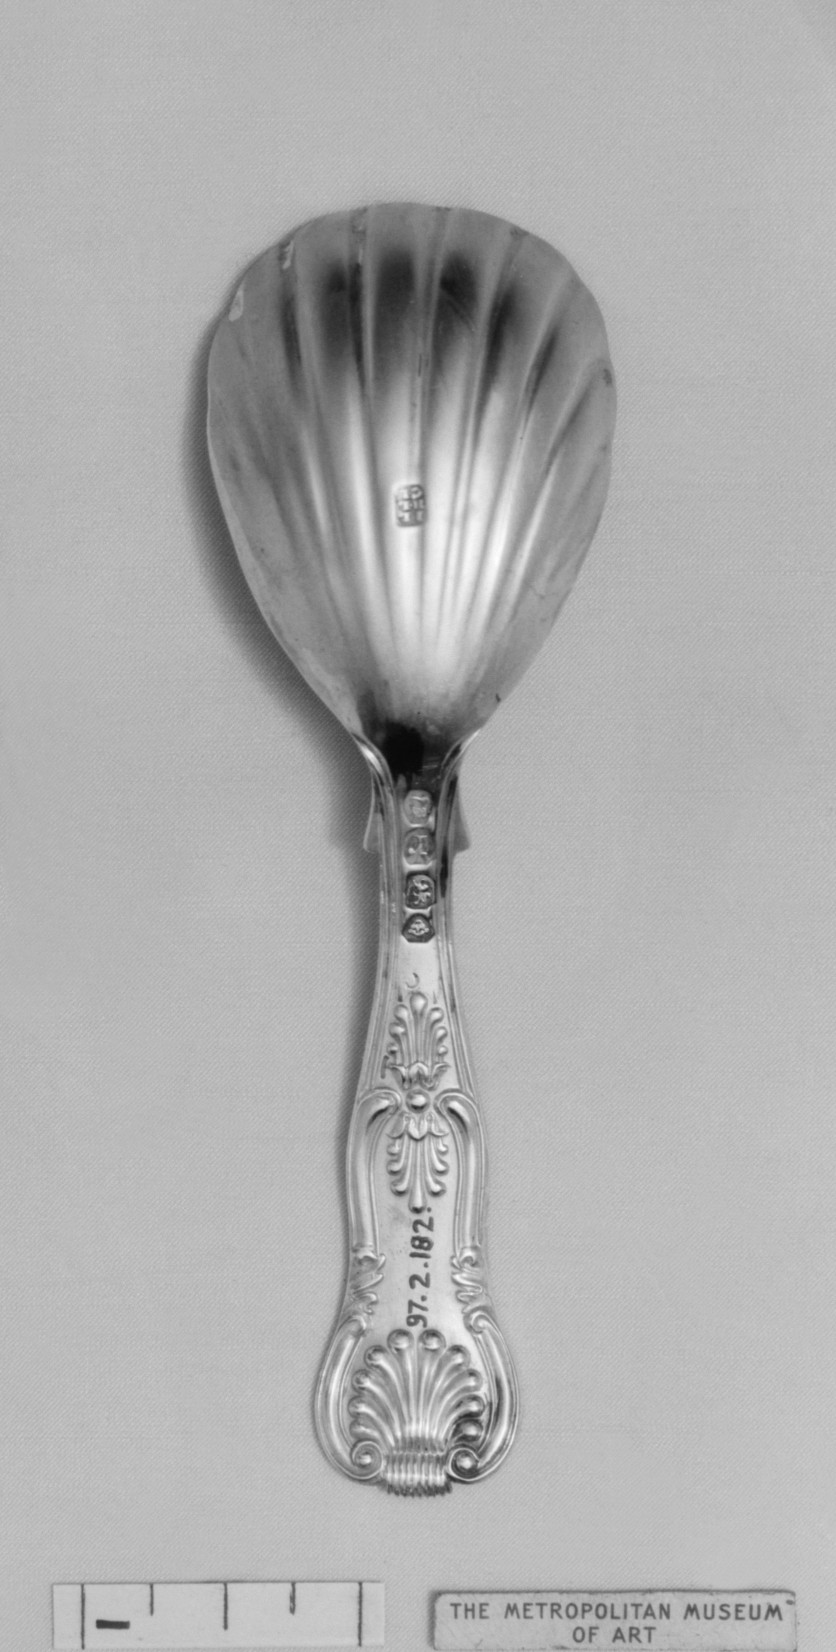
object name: caddy spoon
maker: john lias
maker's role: maker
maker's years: 1791-1837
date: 1832-1833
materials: silver